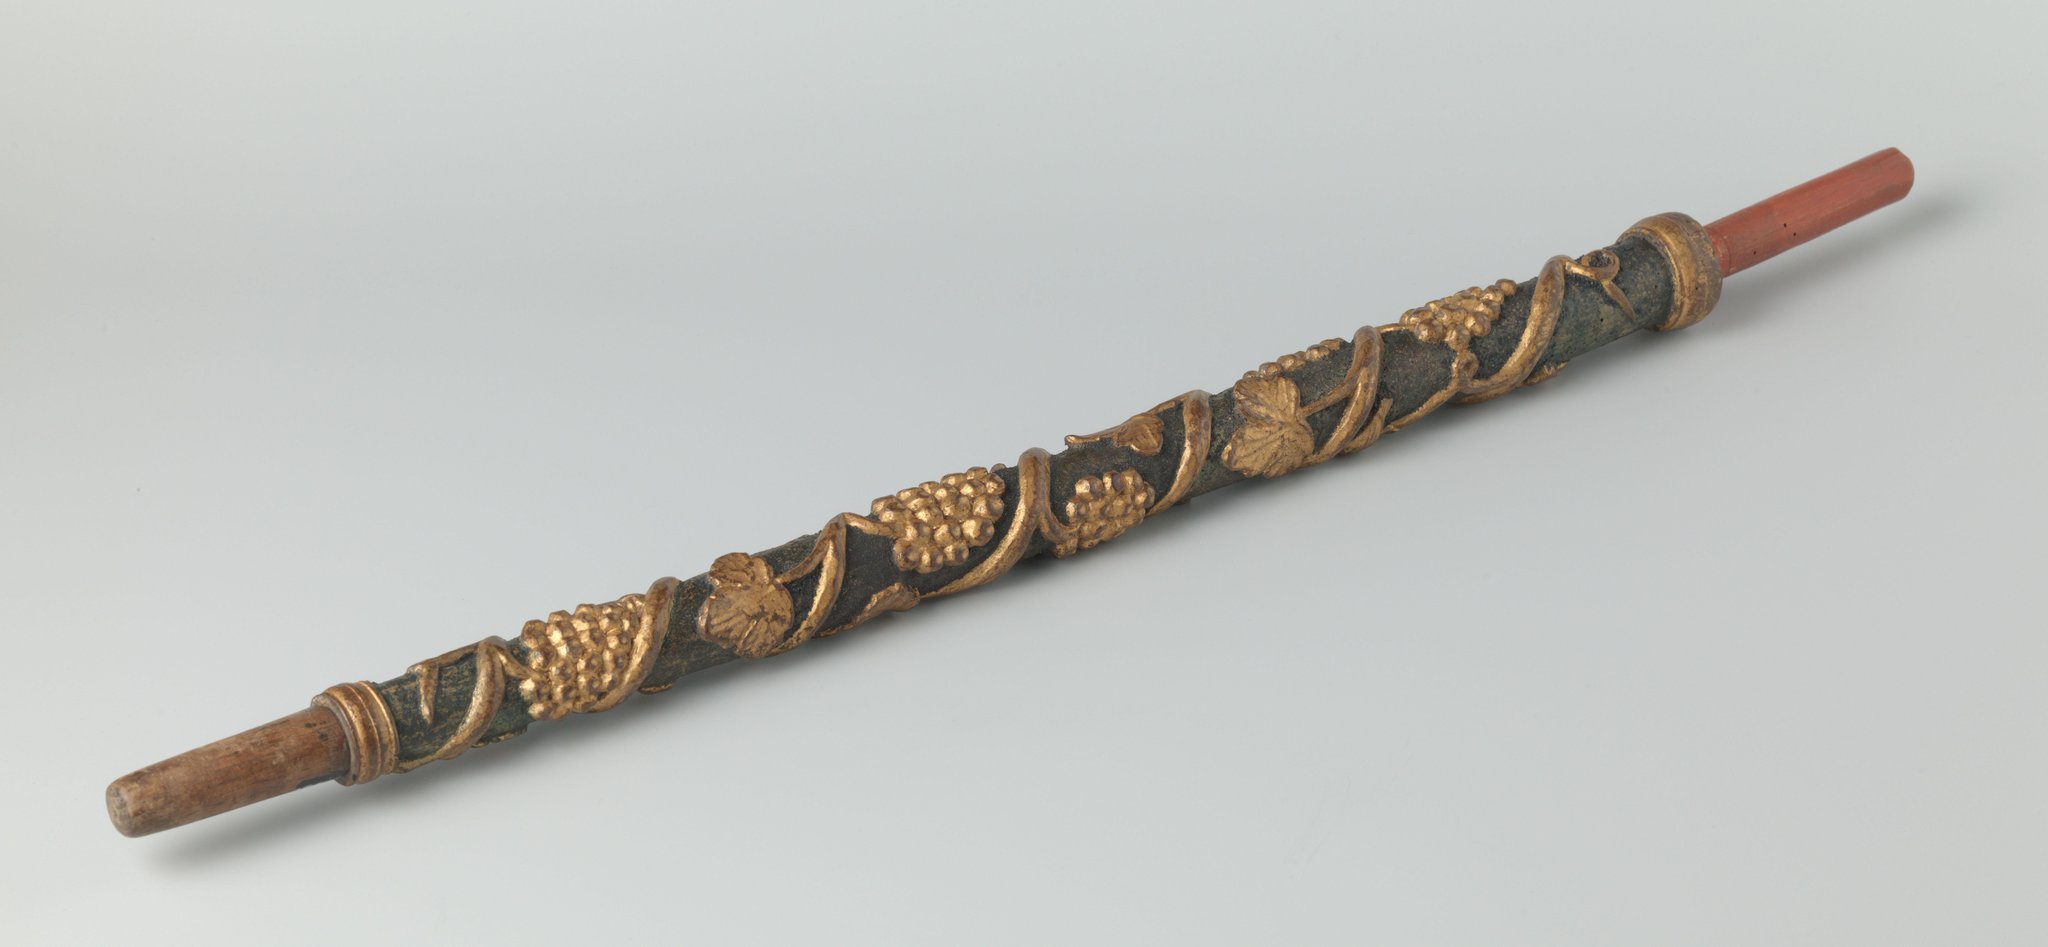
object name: flagpole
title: Vlaggenstok met versiering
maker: Anonymous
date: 1600-1800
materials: wood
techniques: gilding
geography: netherlands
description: Vlaggenstok die versierd is met goudkleurige partonen van wijnranken en druiven. De stok is blauw beschilderd.